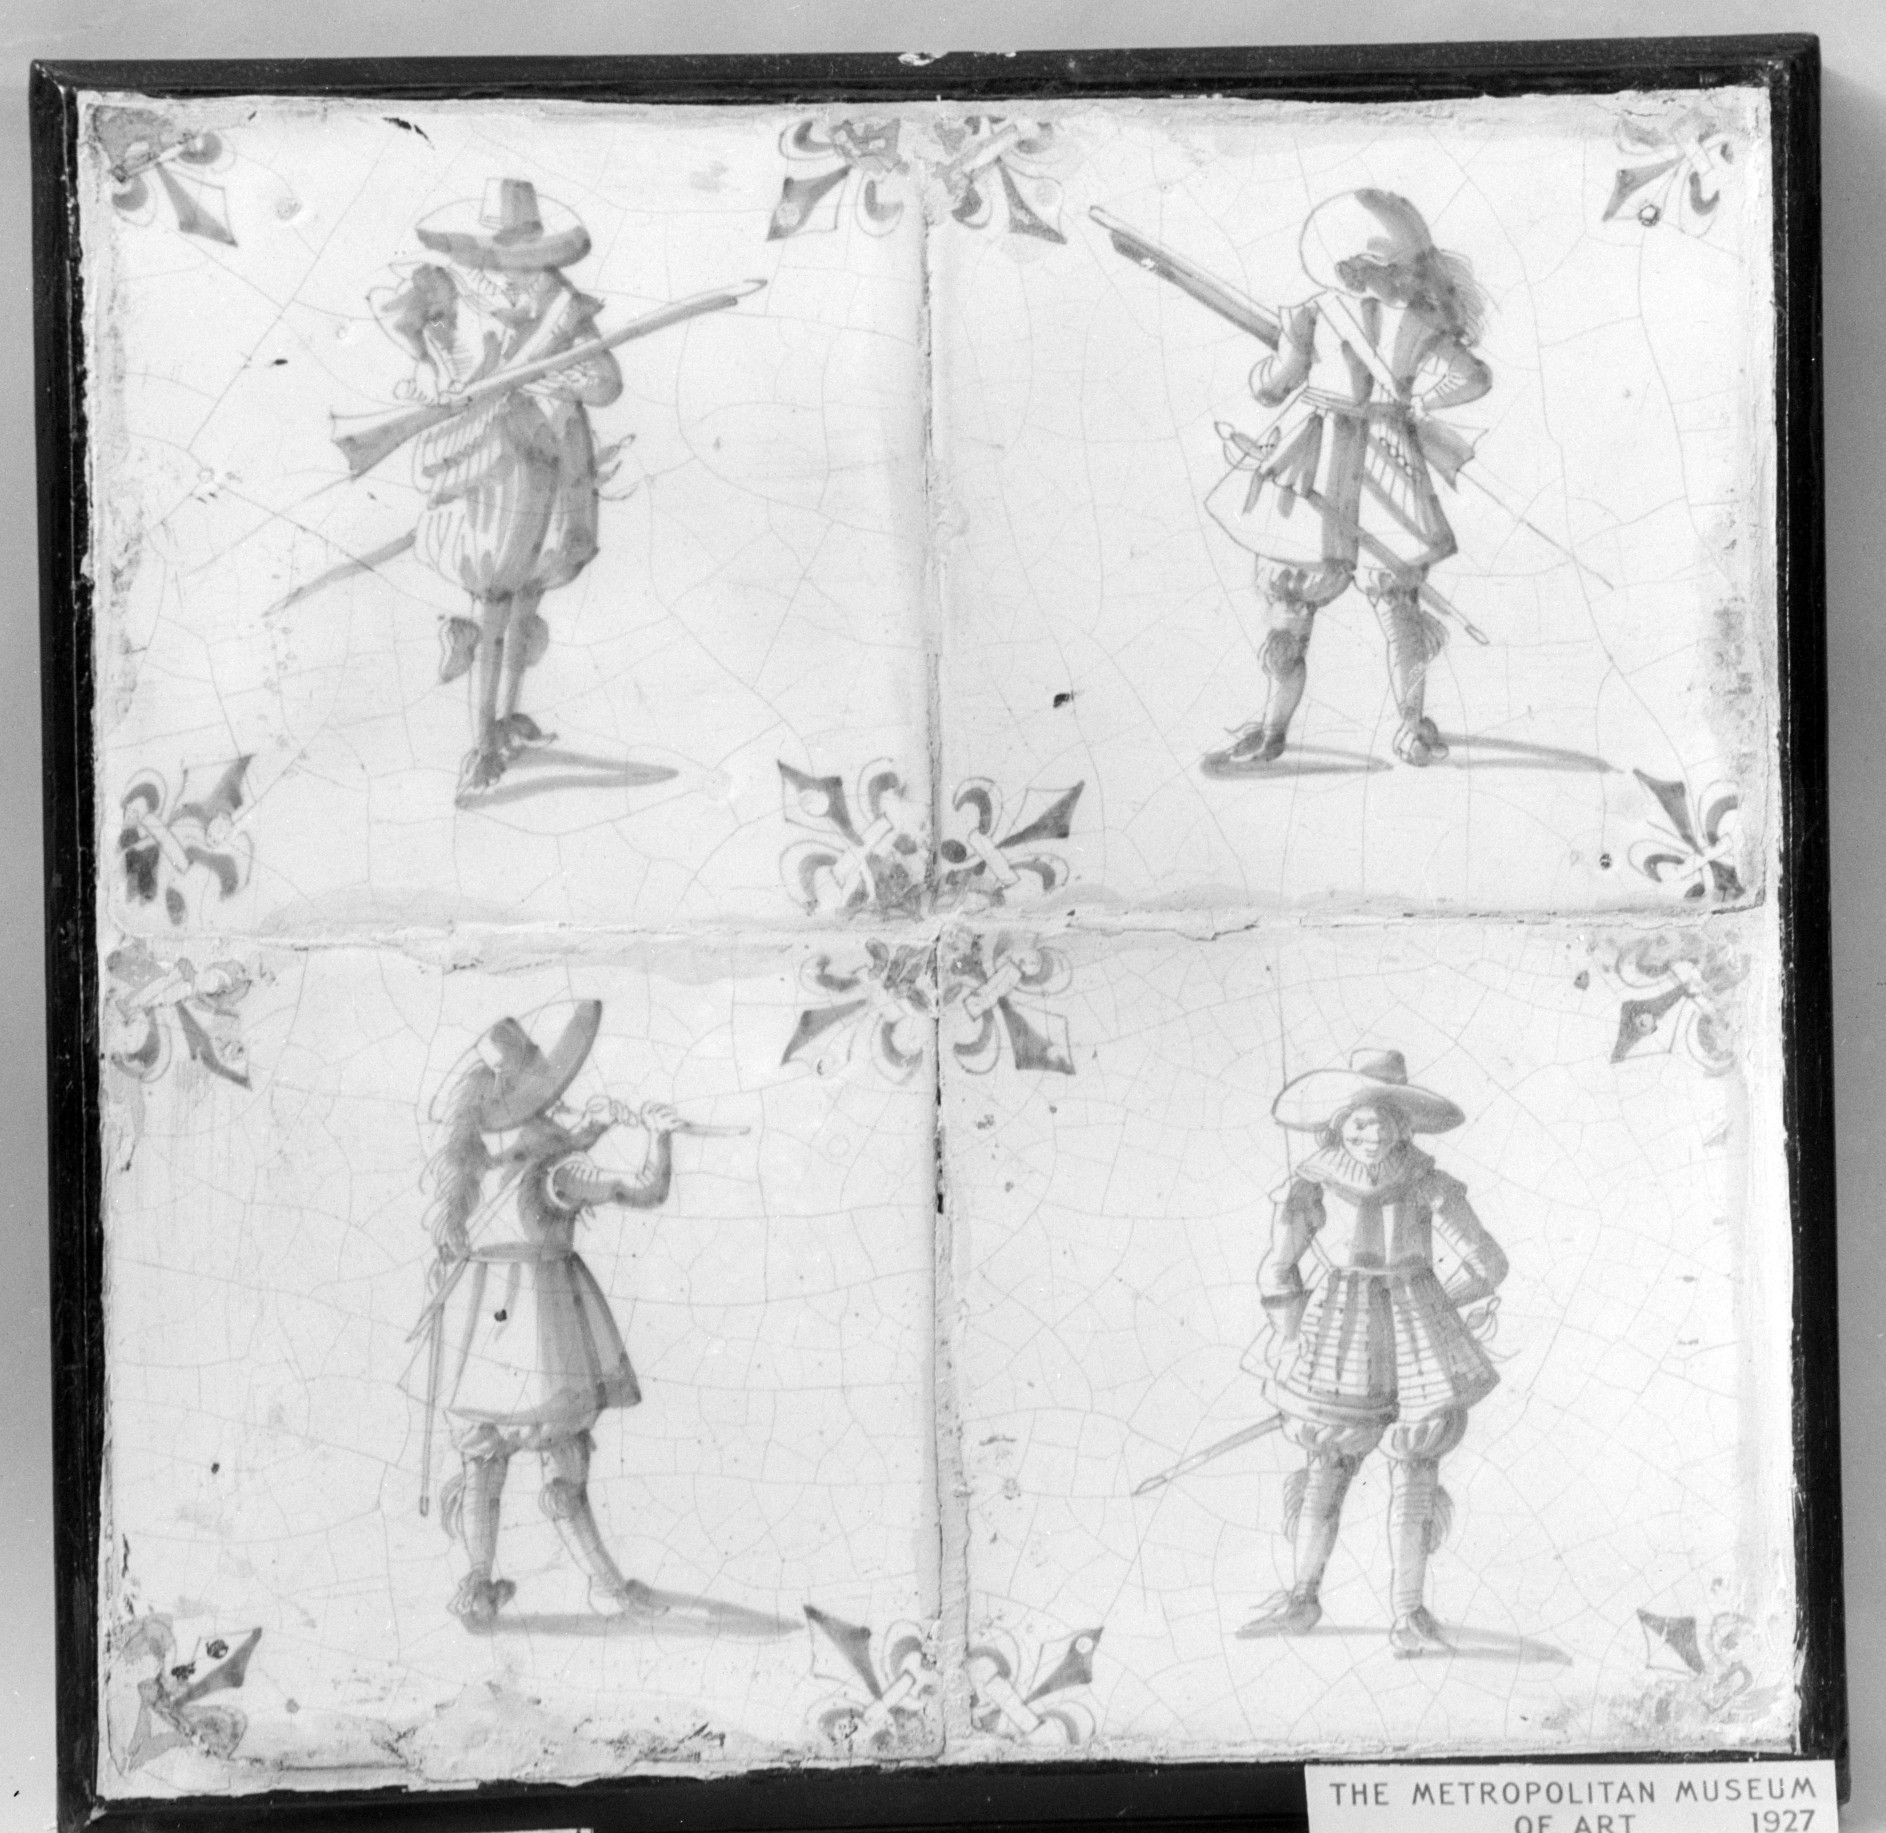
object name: tile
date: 1620-1650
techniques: glazing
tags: men